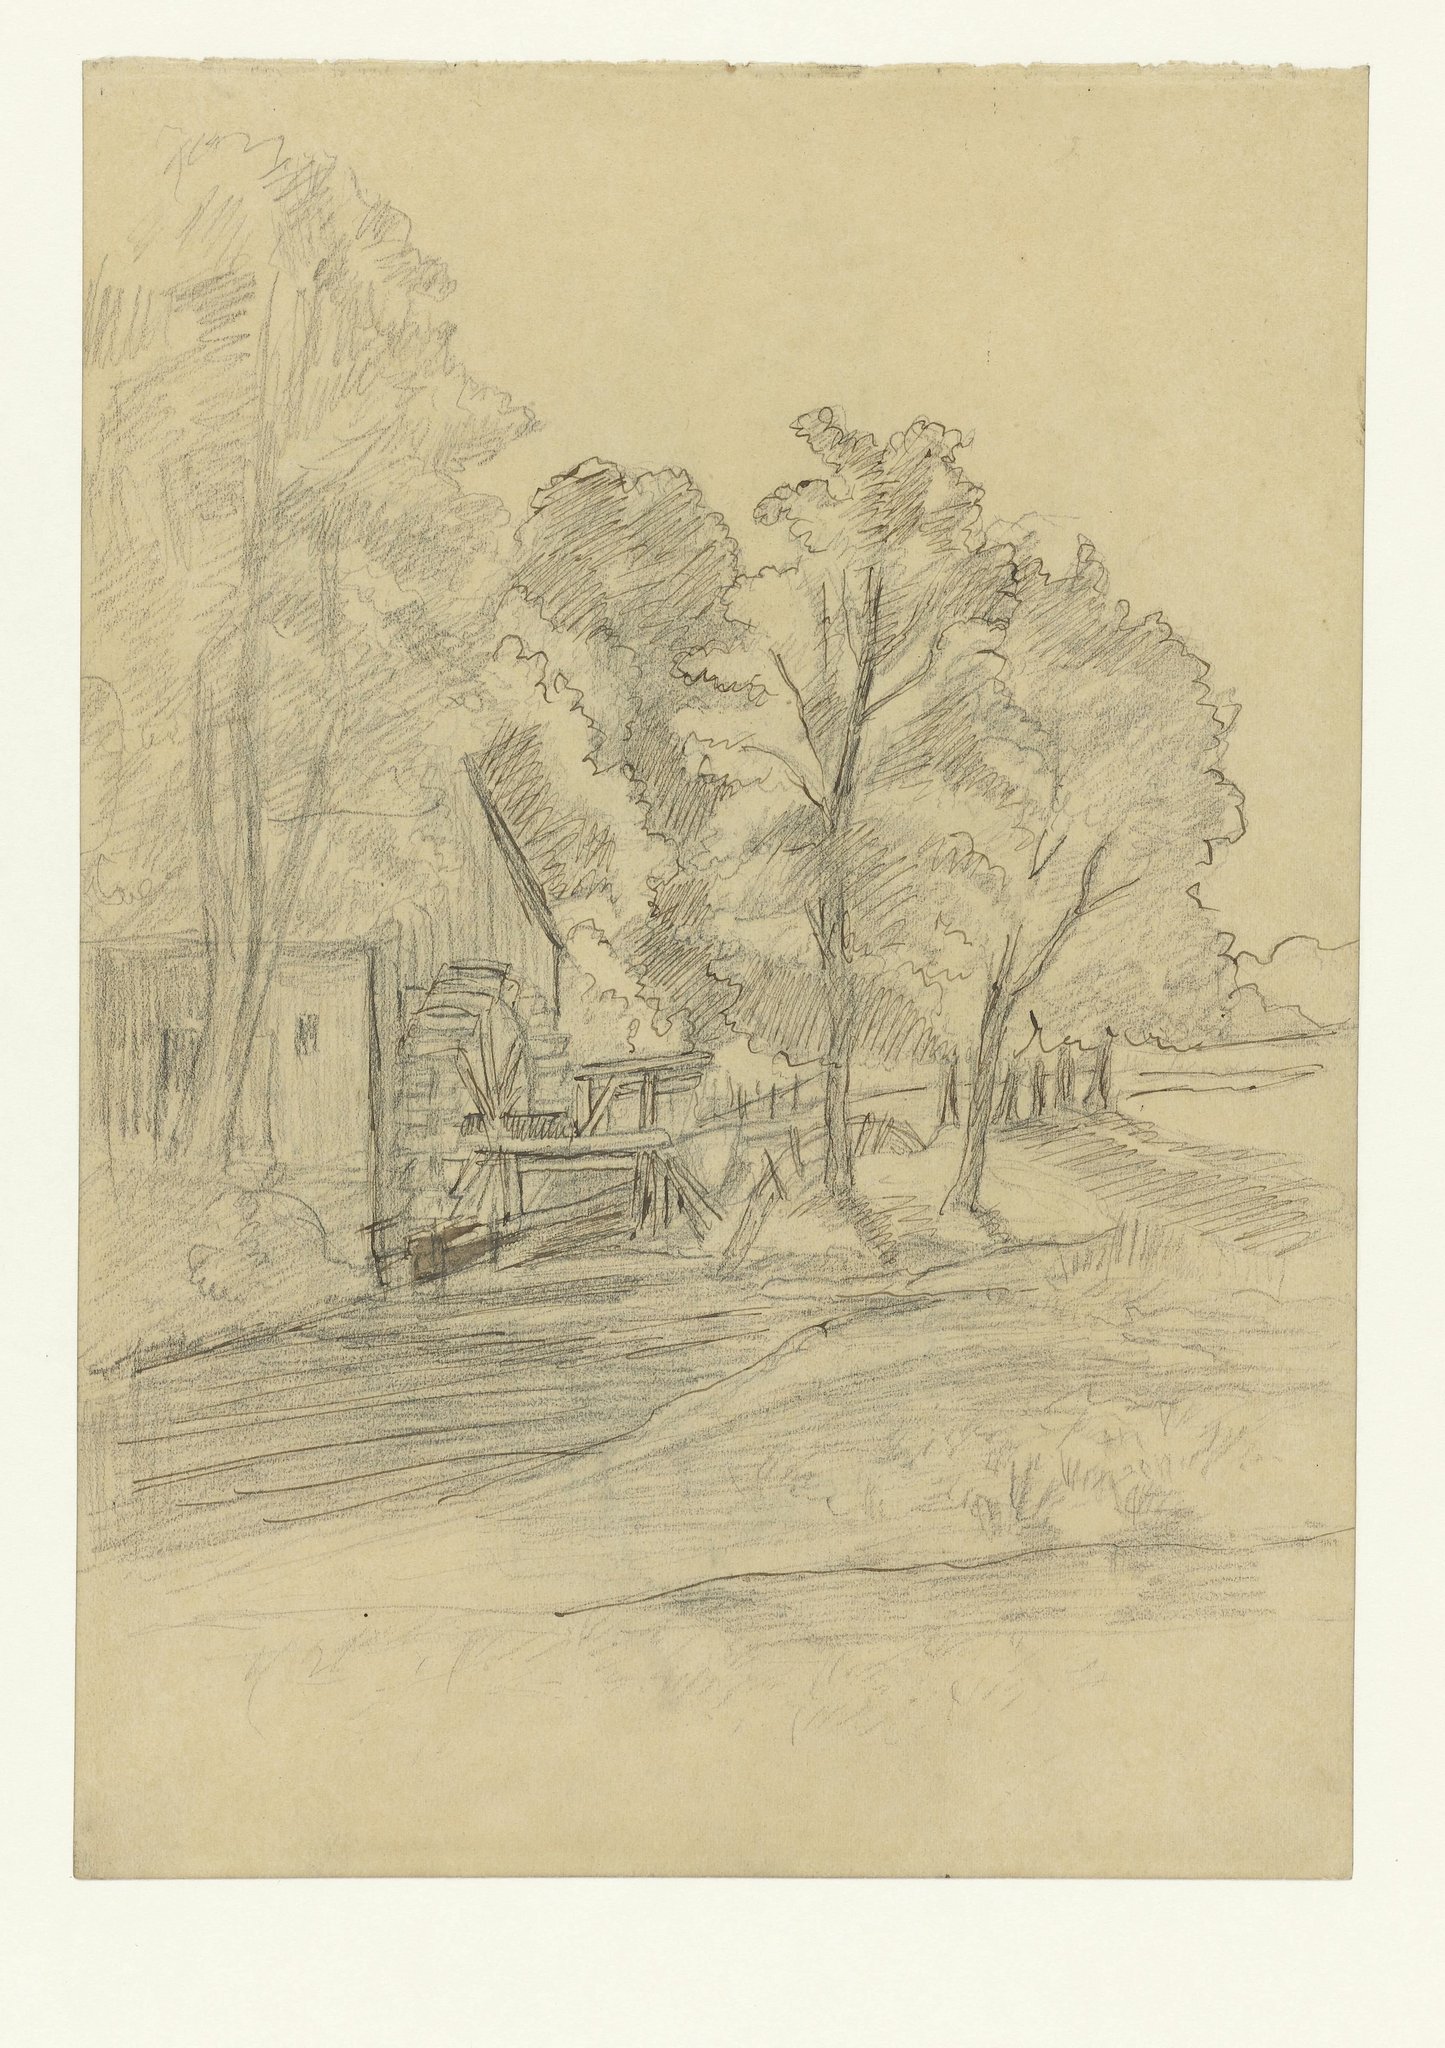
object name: drawing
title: Landschap met een watermolen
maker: jozef israëls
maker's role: draughtsman, painter, print maker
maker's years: 1824-1911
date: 1834-1911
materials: ink, paper, pencil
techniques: pen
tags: watermill in landscape